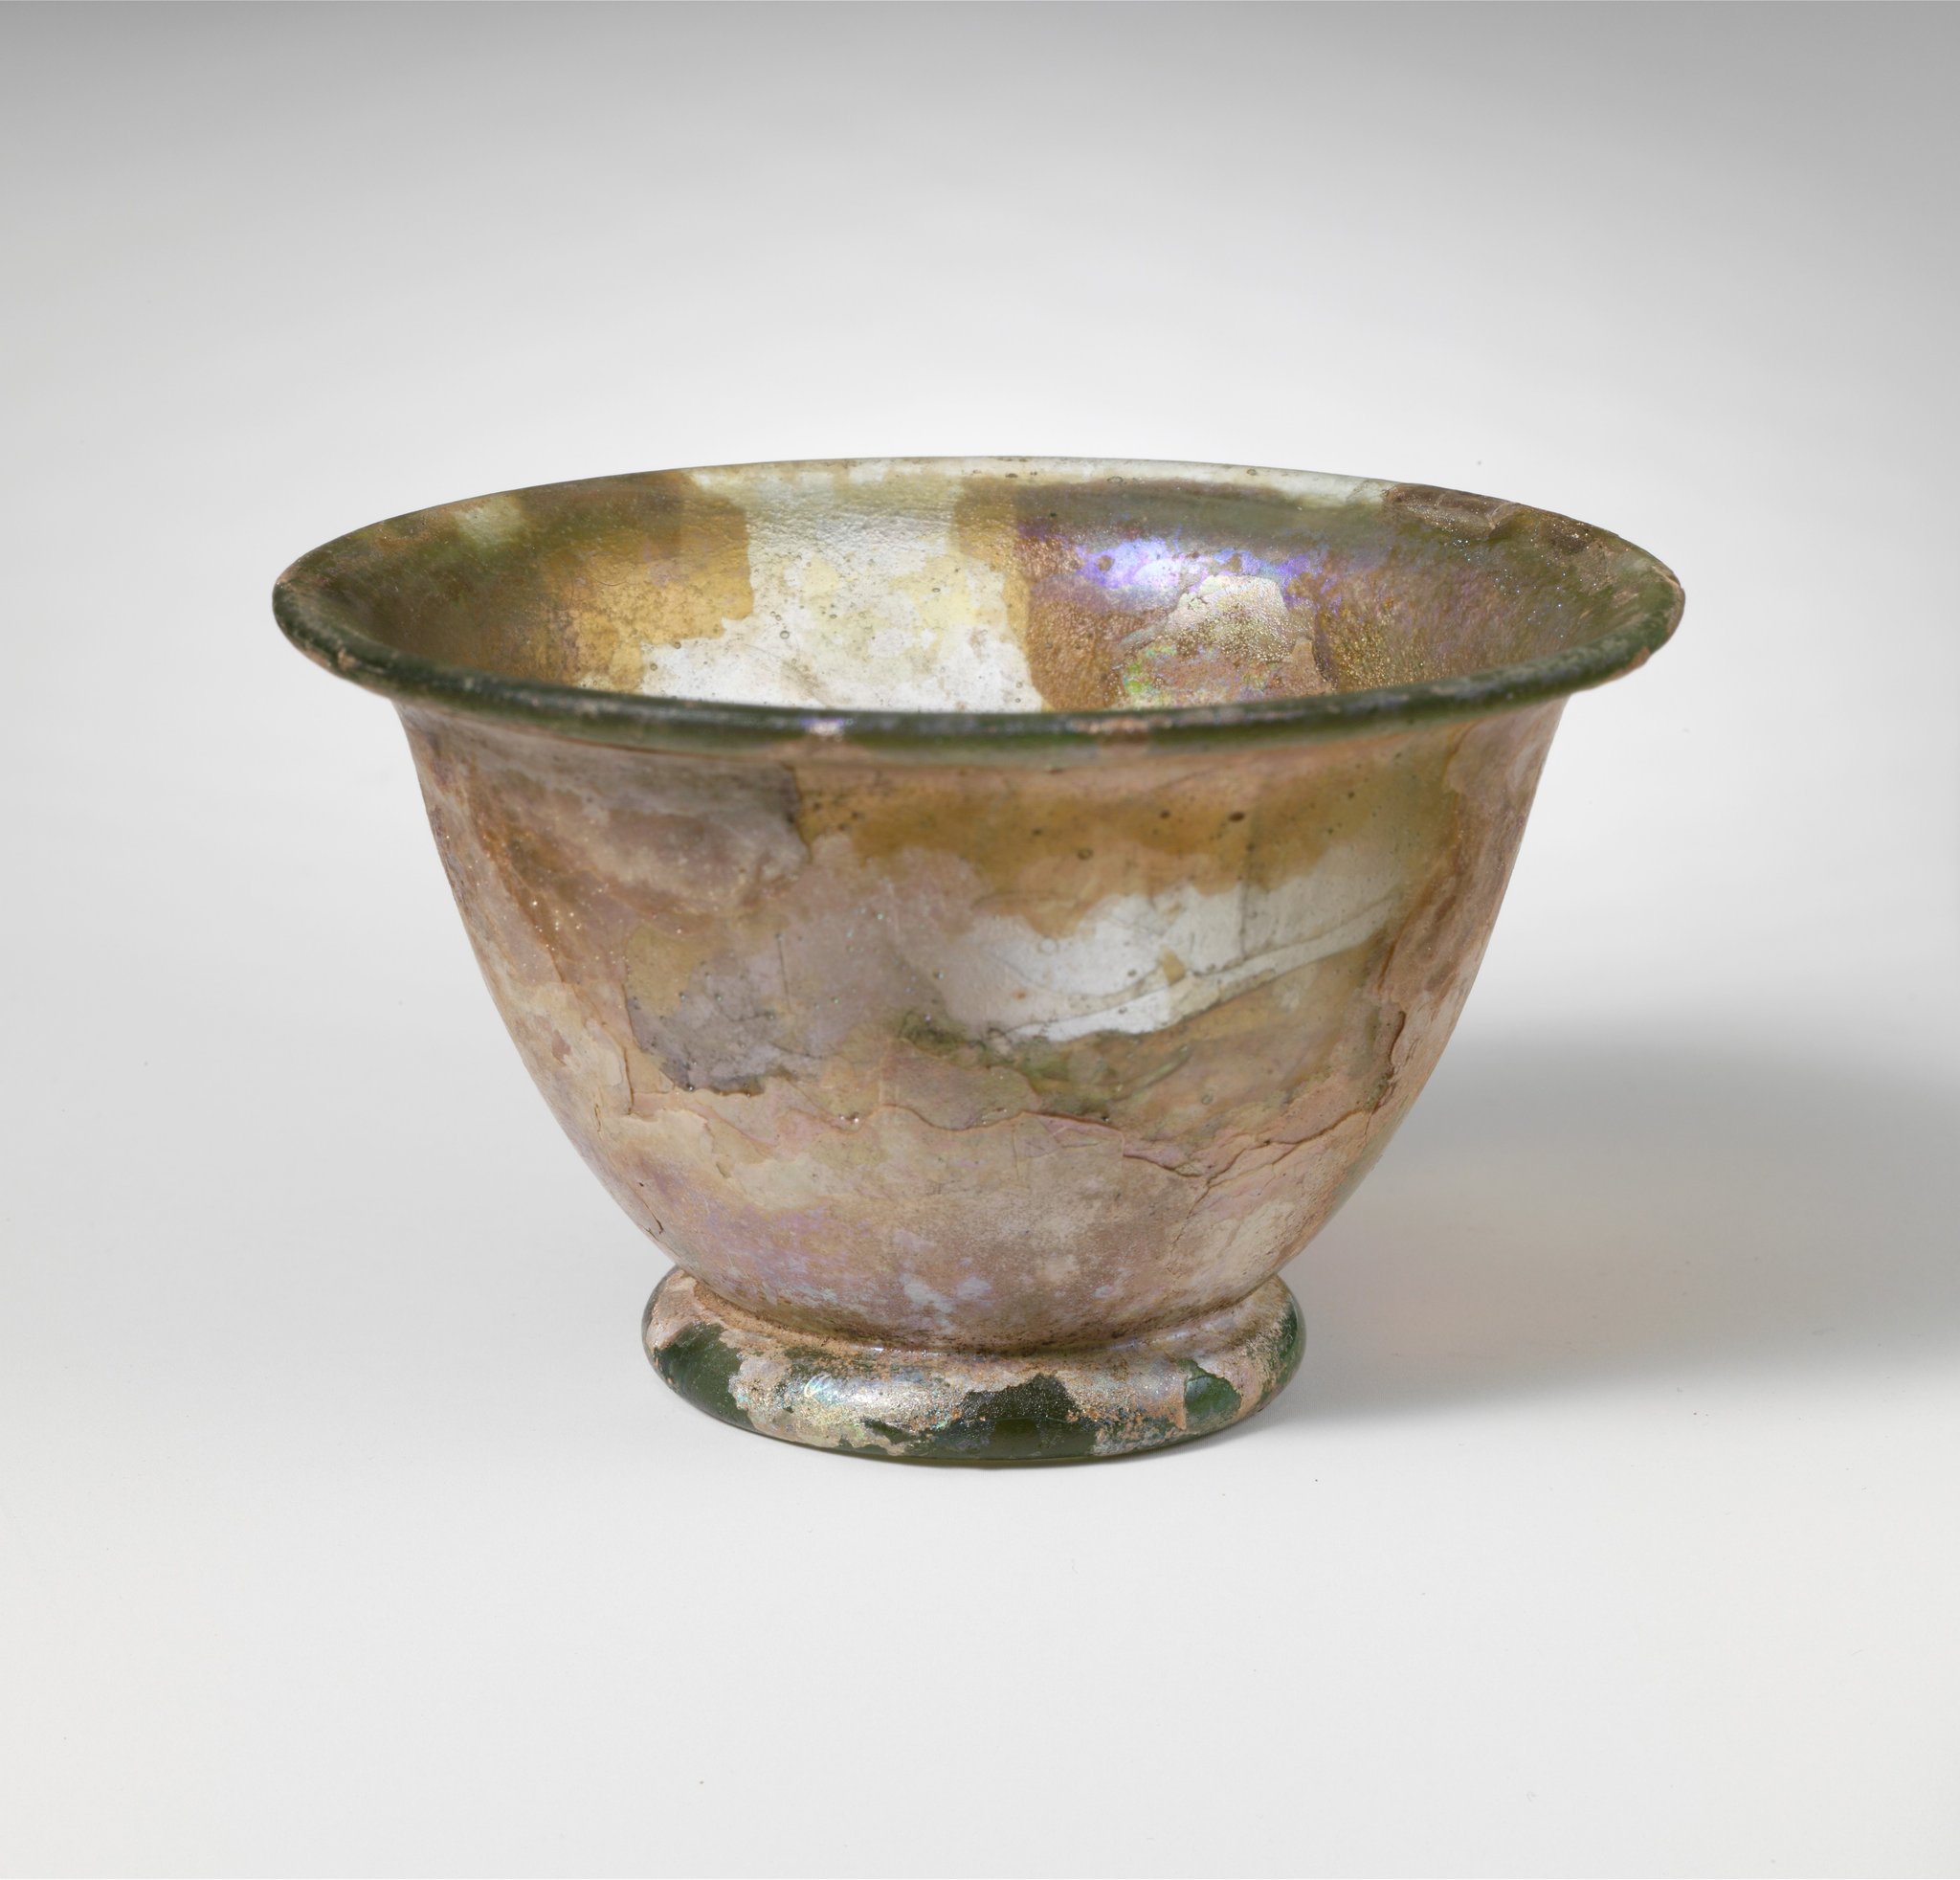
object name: cup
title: Glass cup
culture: roman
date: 101-300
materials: glass